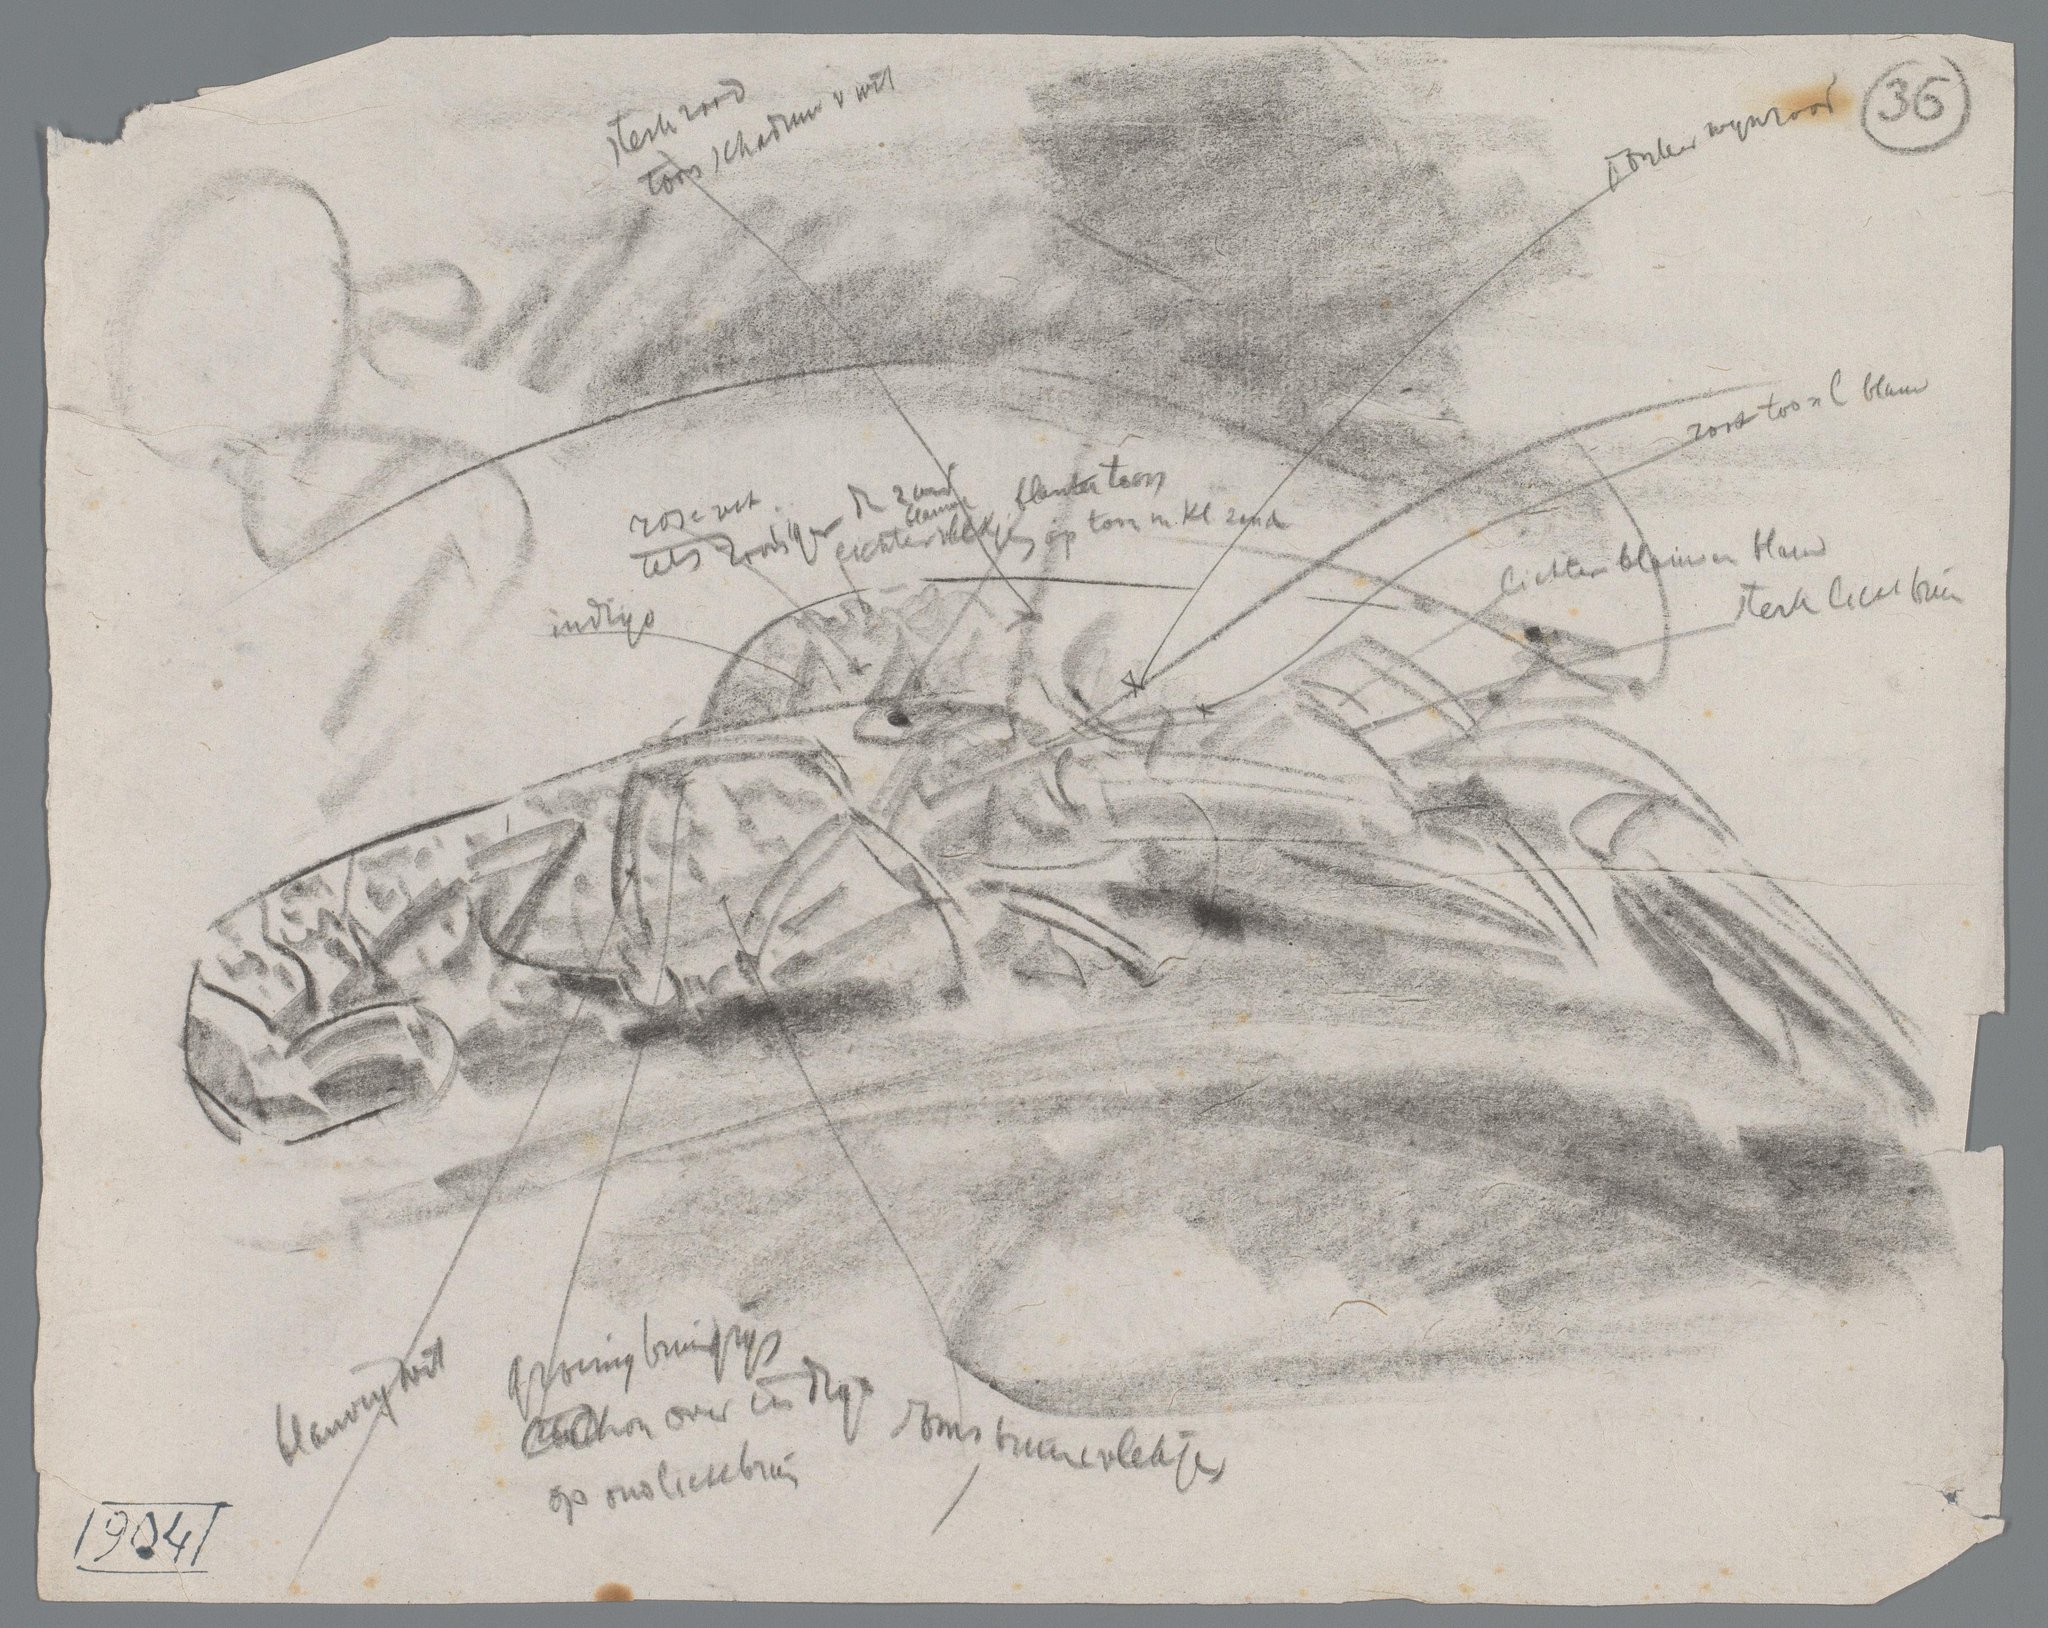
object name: drawing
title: Studie van een kreeft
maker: gerrit willem dijsselhof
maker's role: designer, draughtsman, print maker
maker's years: 1866-1924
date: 1876-1924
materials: chalk, paper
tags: crustaceans: lobster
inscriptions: number: ‘36’, number: ‘904’